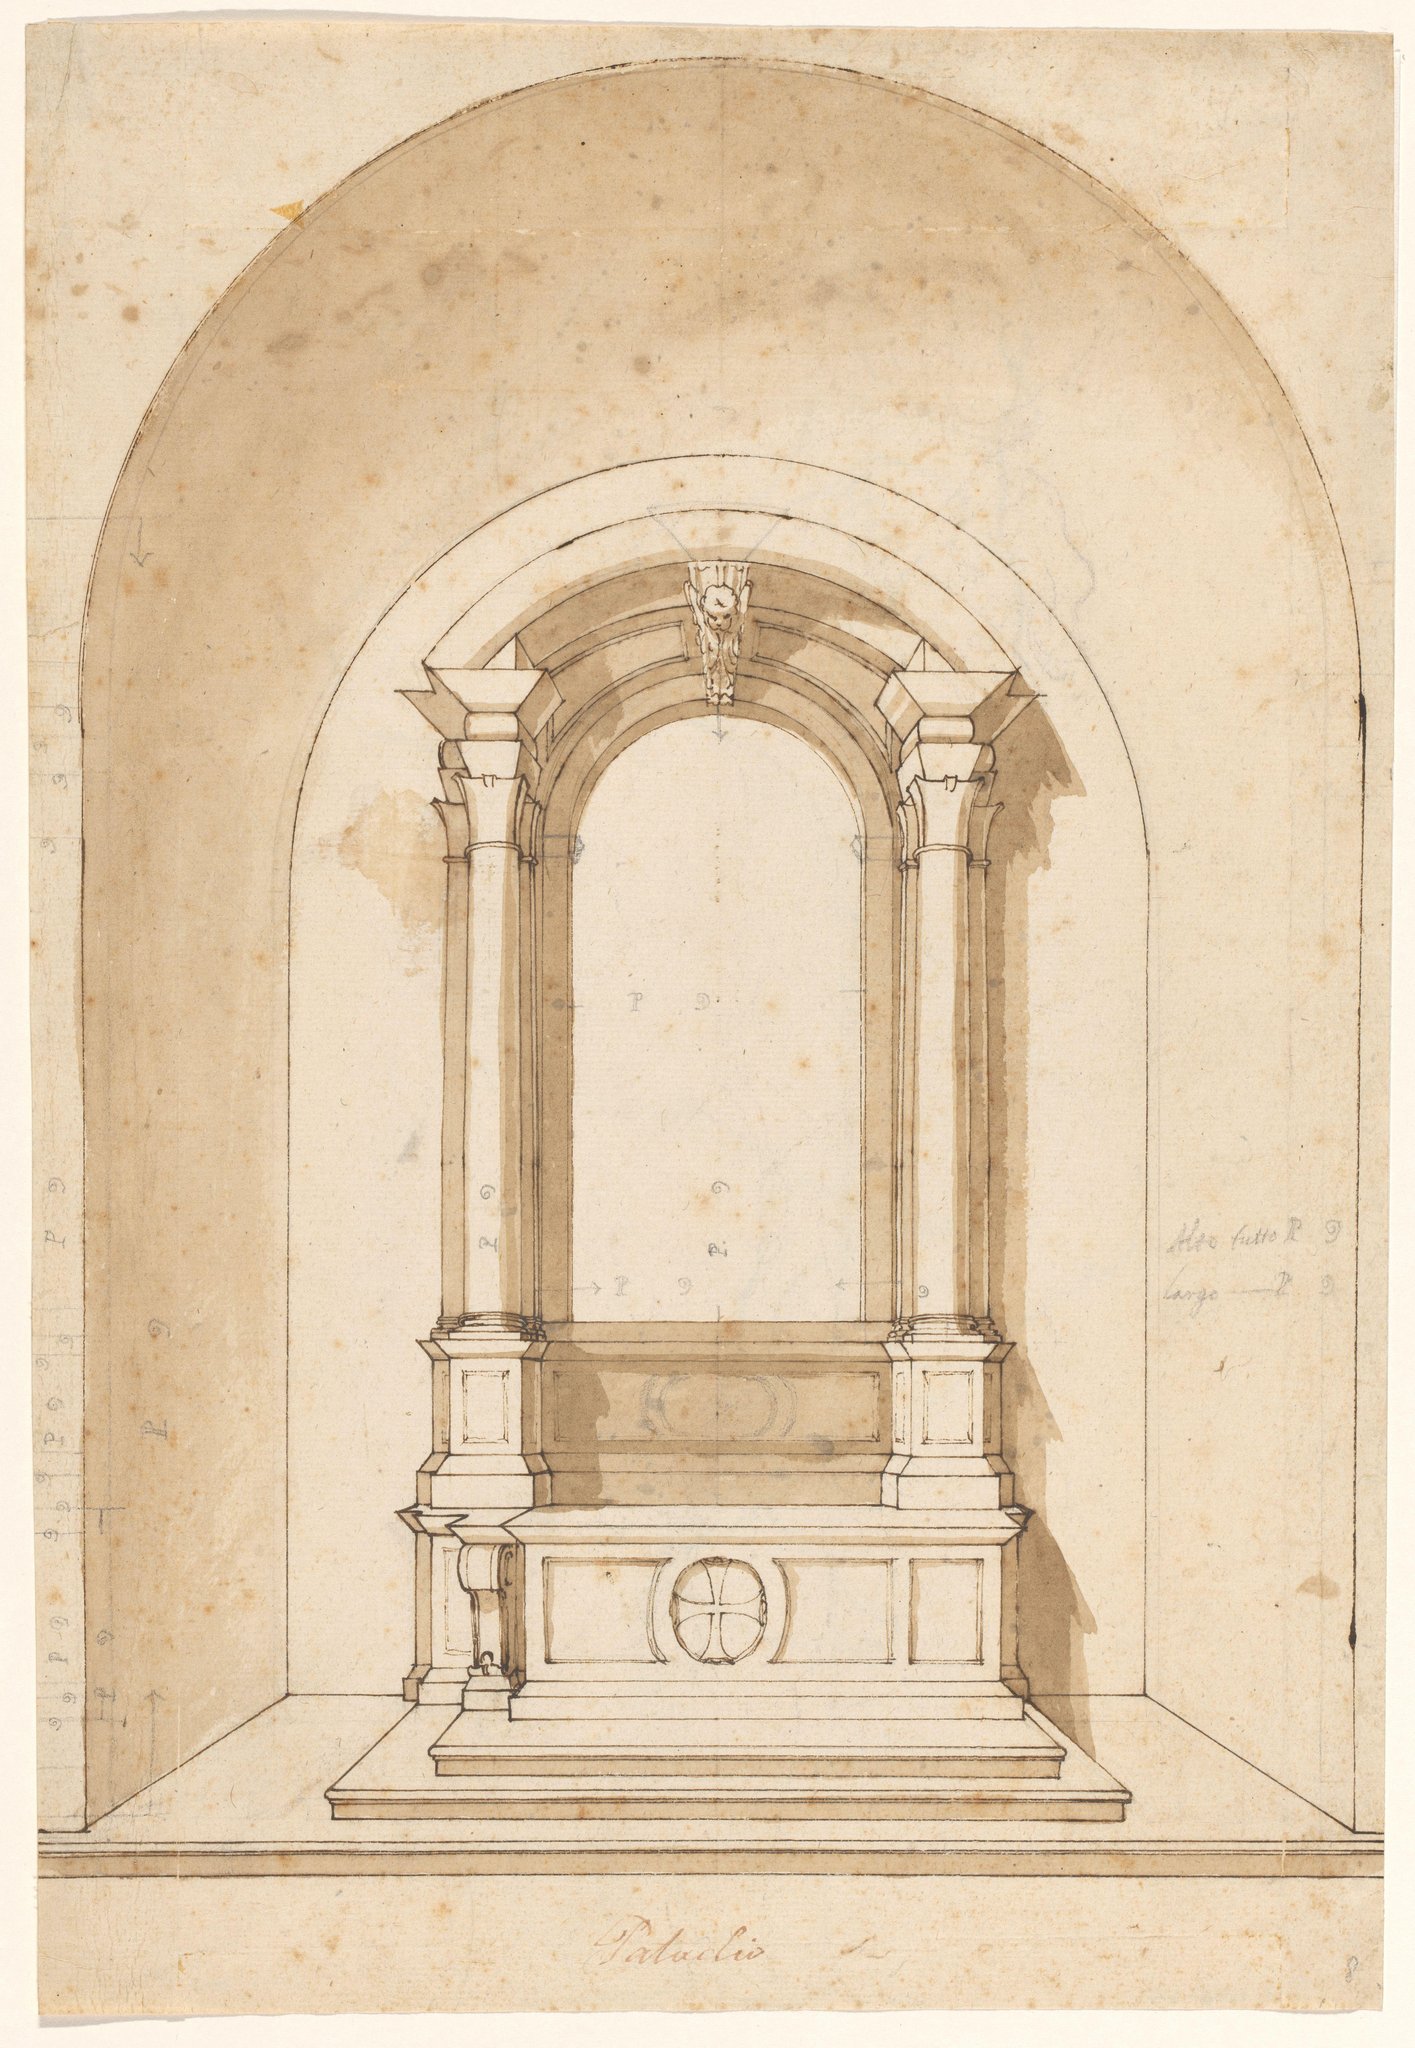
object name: drawing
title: Ontwerp voor een altaar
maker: andrea palladio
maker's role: architect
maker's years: 1508-1580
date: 1518-1599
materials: ink, paper, pencil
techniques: brush, pen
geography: italy